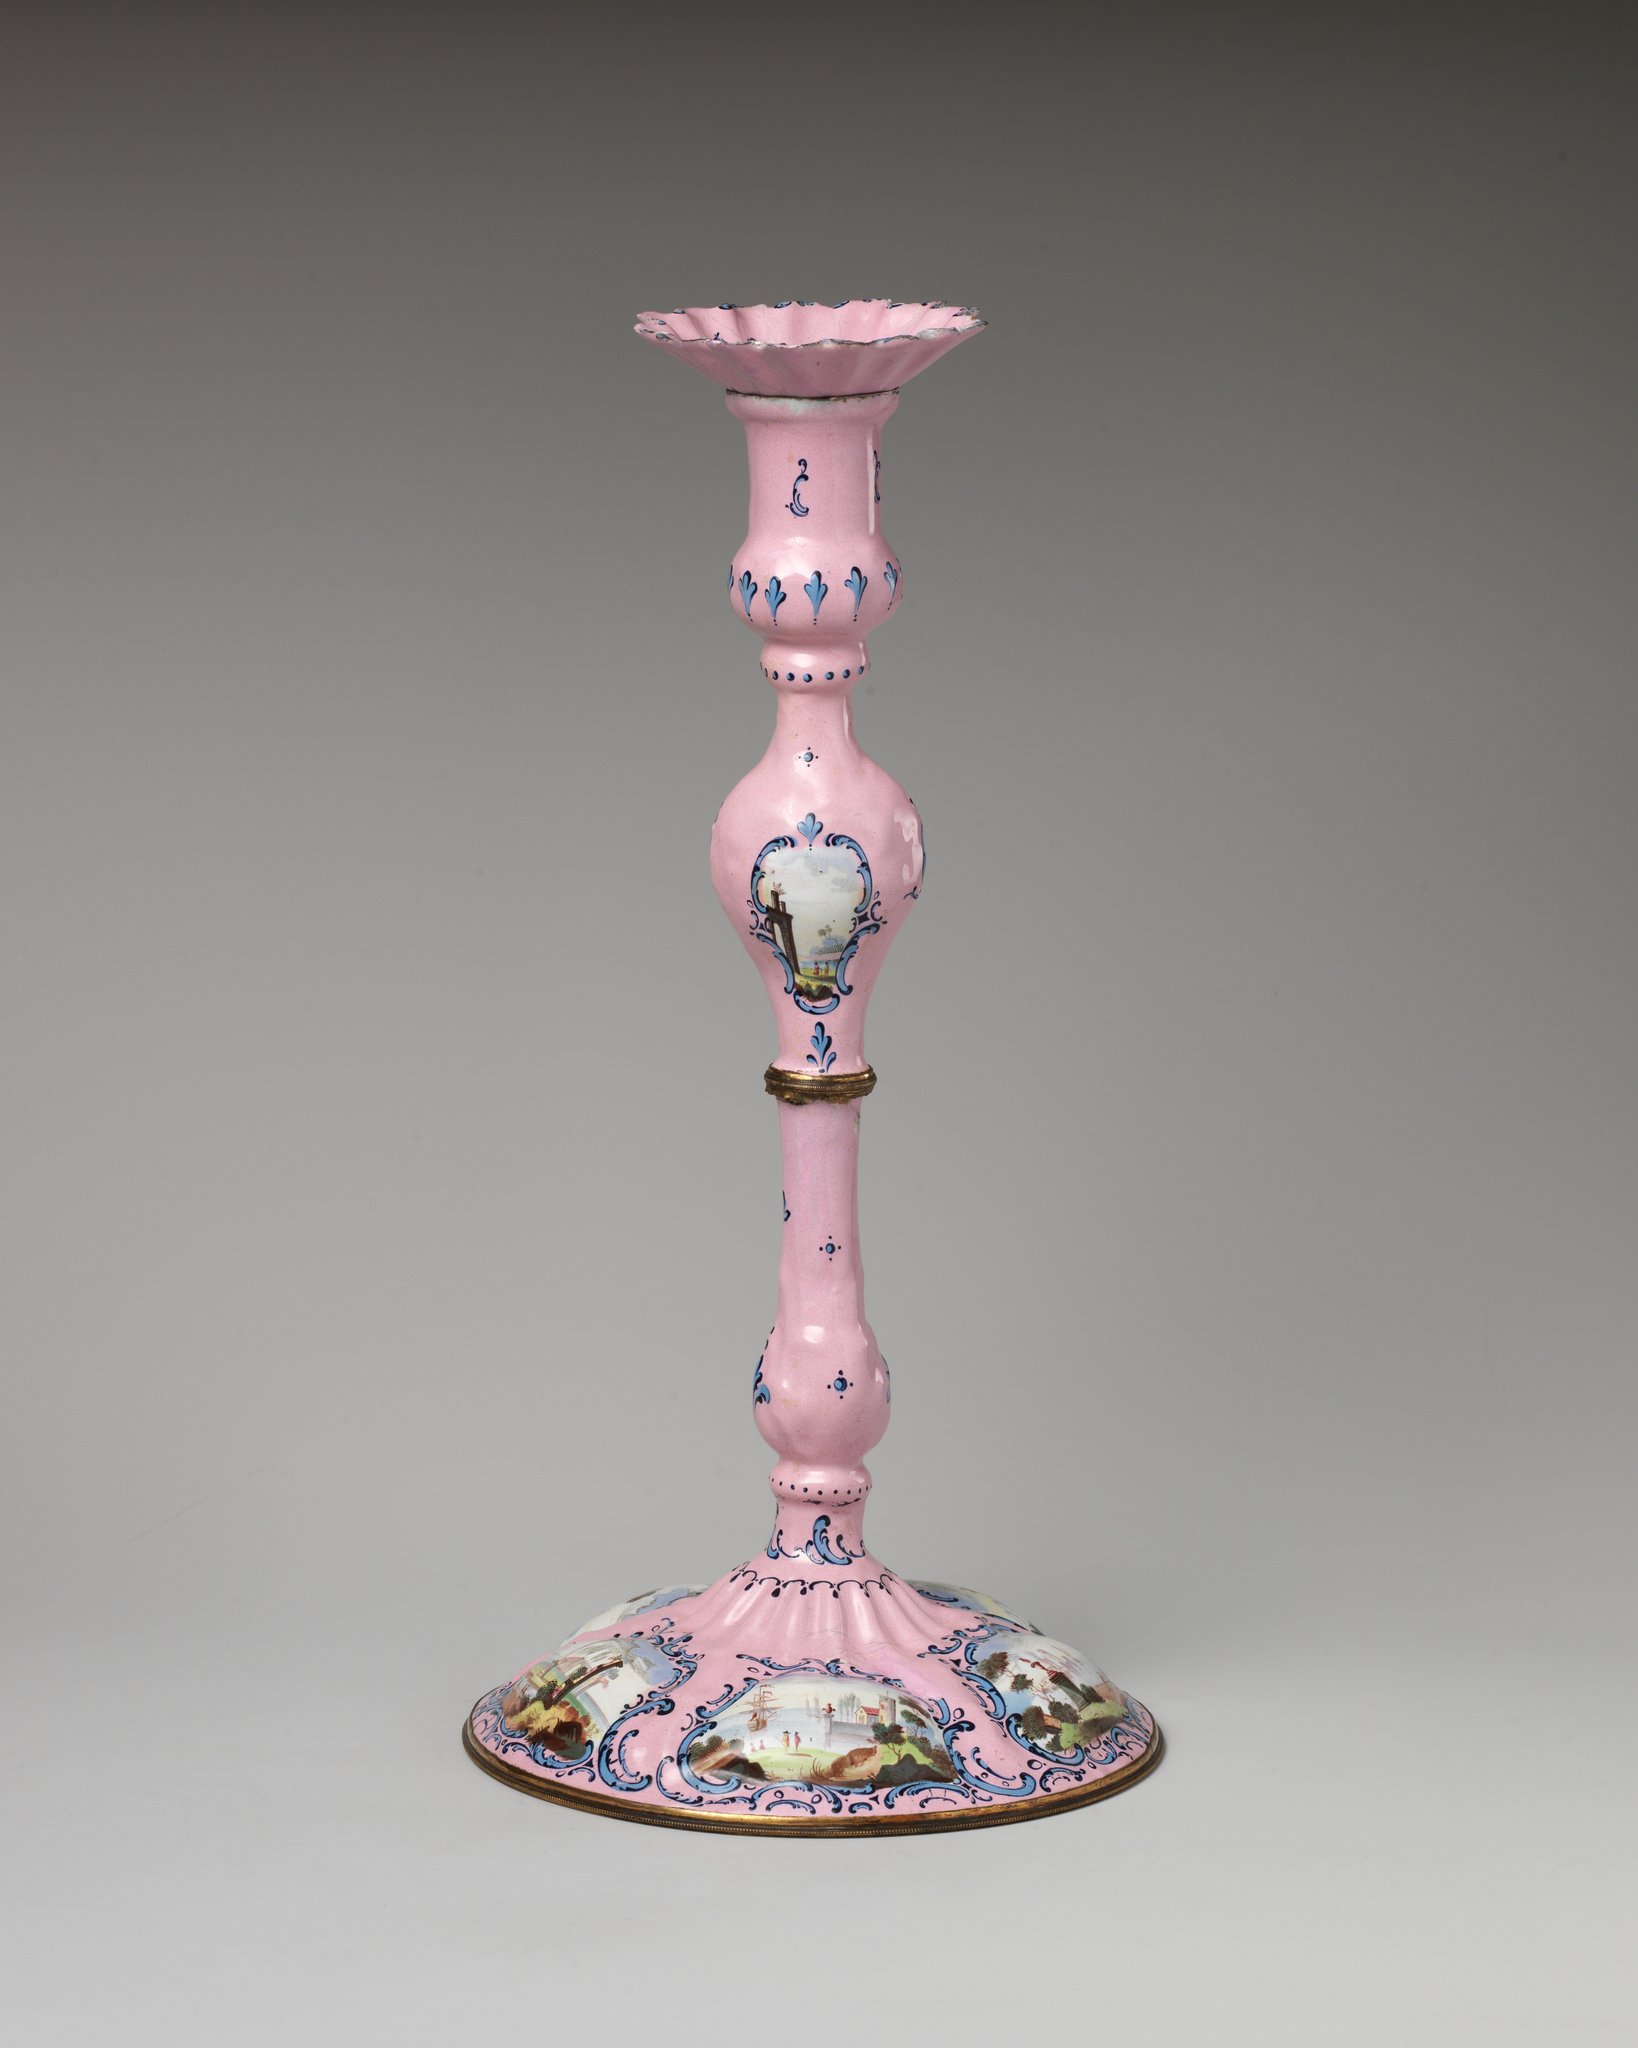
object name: candlestick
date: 1700-1800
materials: copper, enamel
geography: england